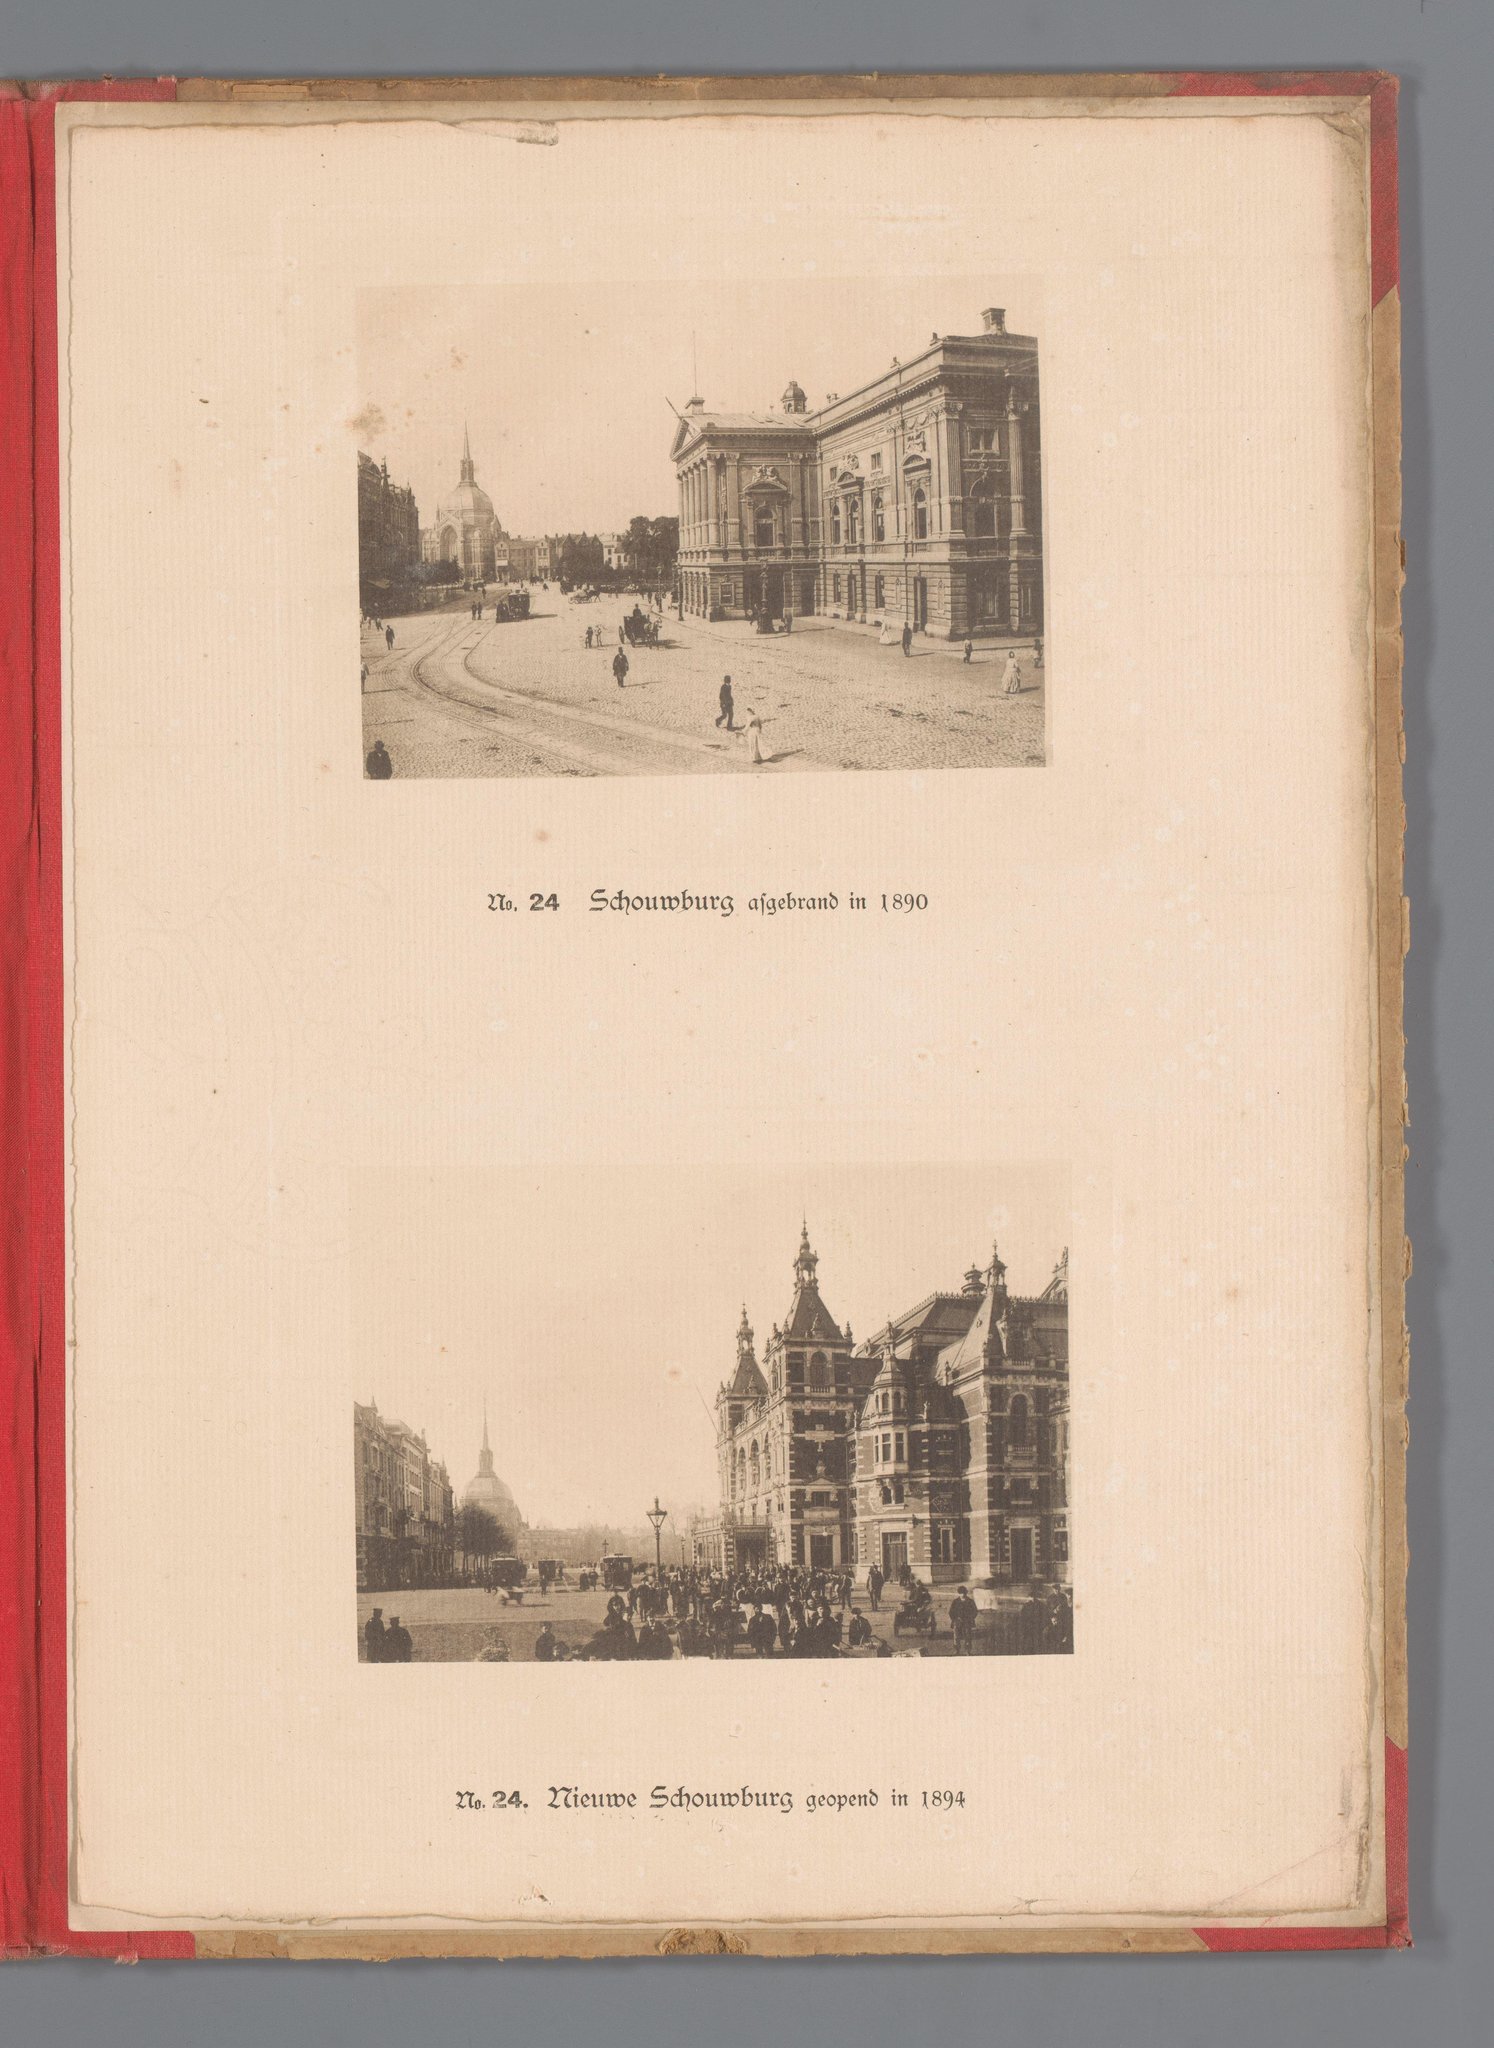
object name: photomechanical print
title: No. 24. Nieuwe Schouwburg geopend in 1894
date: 1894-1900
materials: paper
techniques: photograph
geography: amsterdam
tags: theatre (building), square, place, circus, etc. (+ city(-scape) with figures, staffage)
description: Deze prenten maken deel uit van een album.